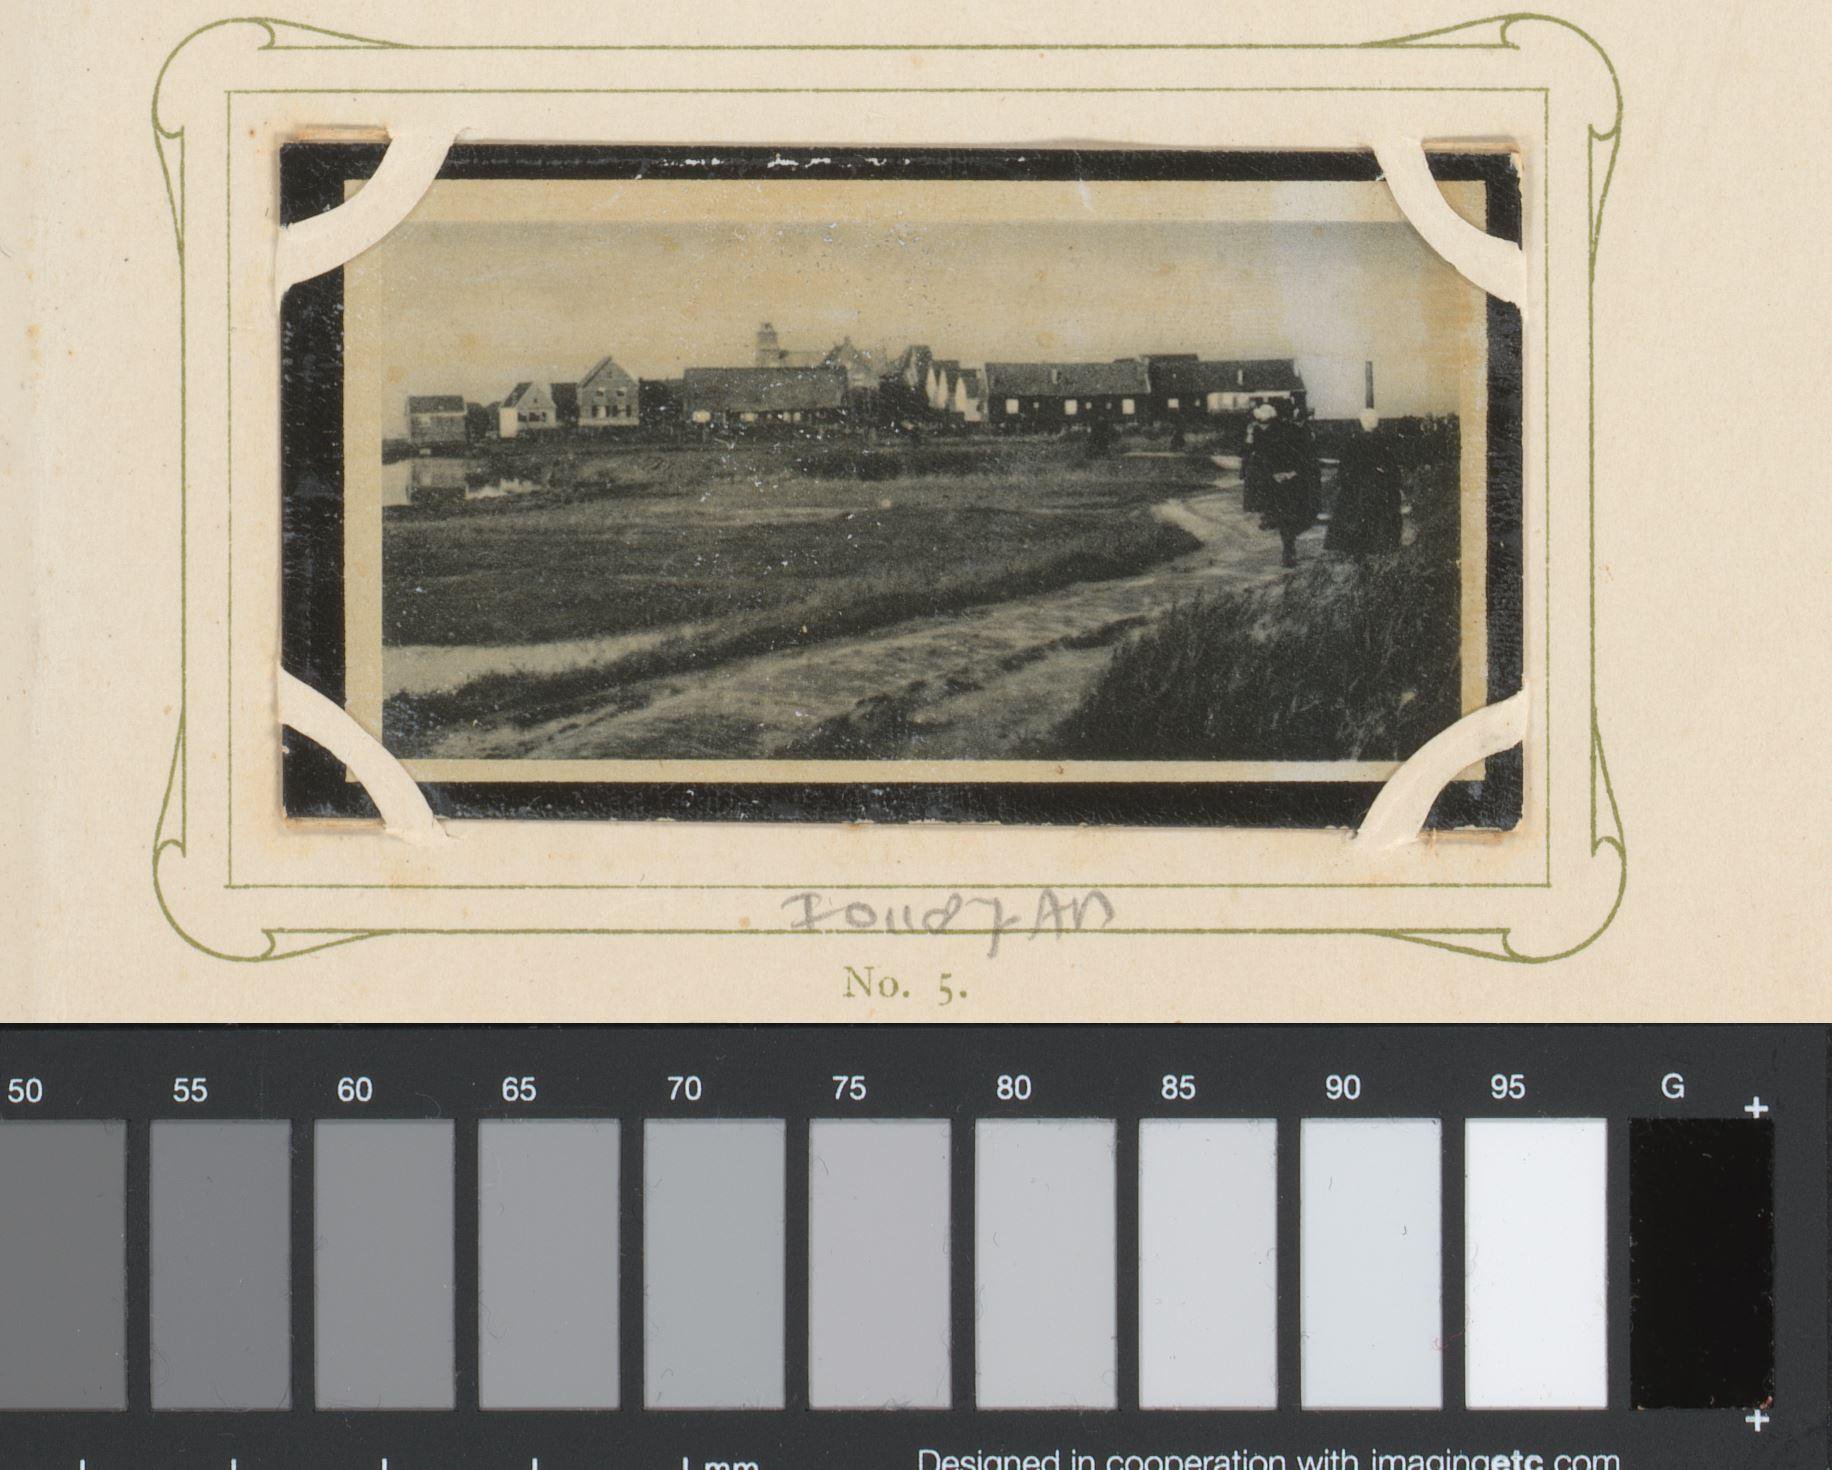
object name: album leaf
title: Mensen op een weg, met op de achtergrond een dorp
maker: Anonymous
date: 1905-1906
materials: paper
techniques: photograph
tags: prospect of village, silhouette of village, road, path (+ four persons or more ~ traffic and transport)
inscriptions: inscription: ‘No. 5./ Weg naar het dorp.’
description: Deze prent maakt deel uit van een album.